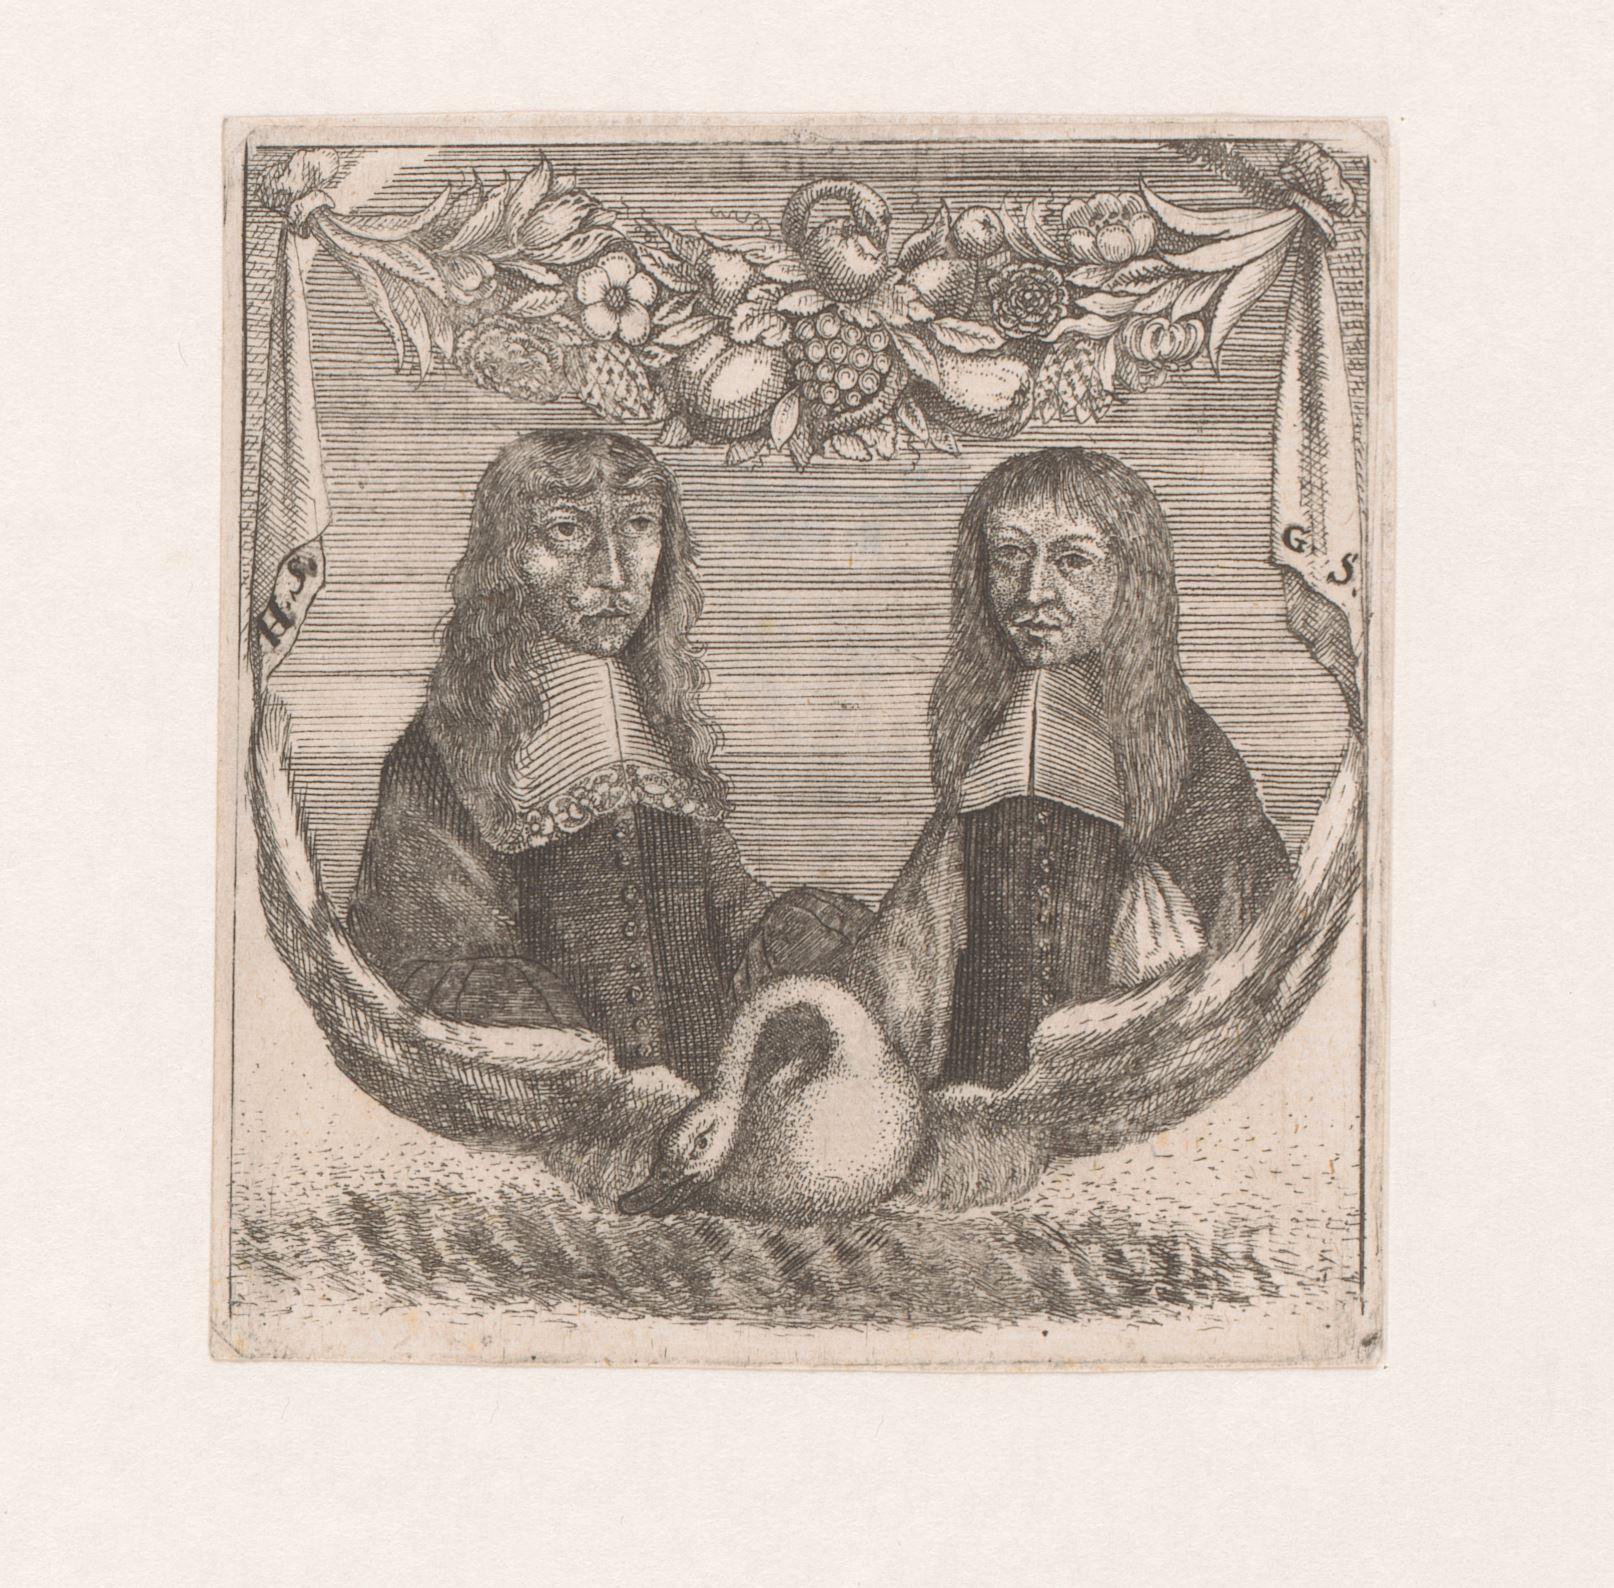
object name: print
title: Dubbelportret van de broers H en G Schanhard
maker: johann reinhold mühl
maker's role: print maker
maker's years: 1631-1692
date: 1641-1691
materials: paper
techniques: etching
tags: water-birds: swan, historical persons, fruits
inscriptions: collector's mark: Lugt 2228